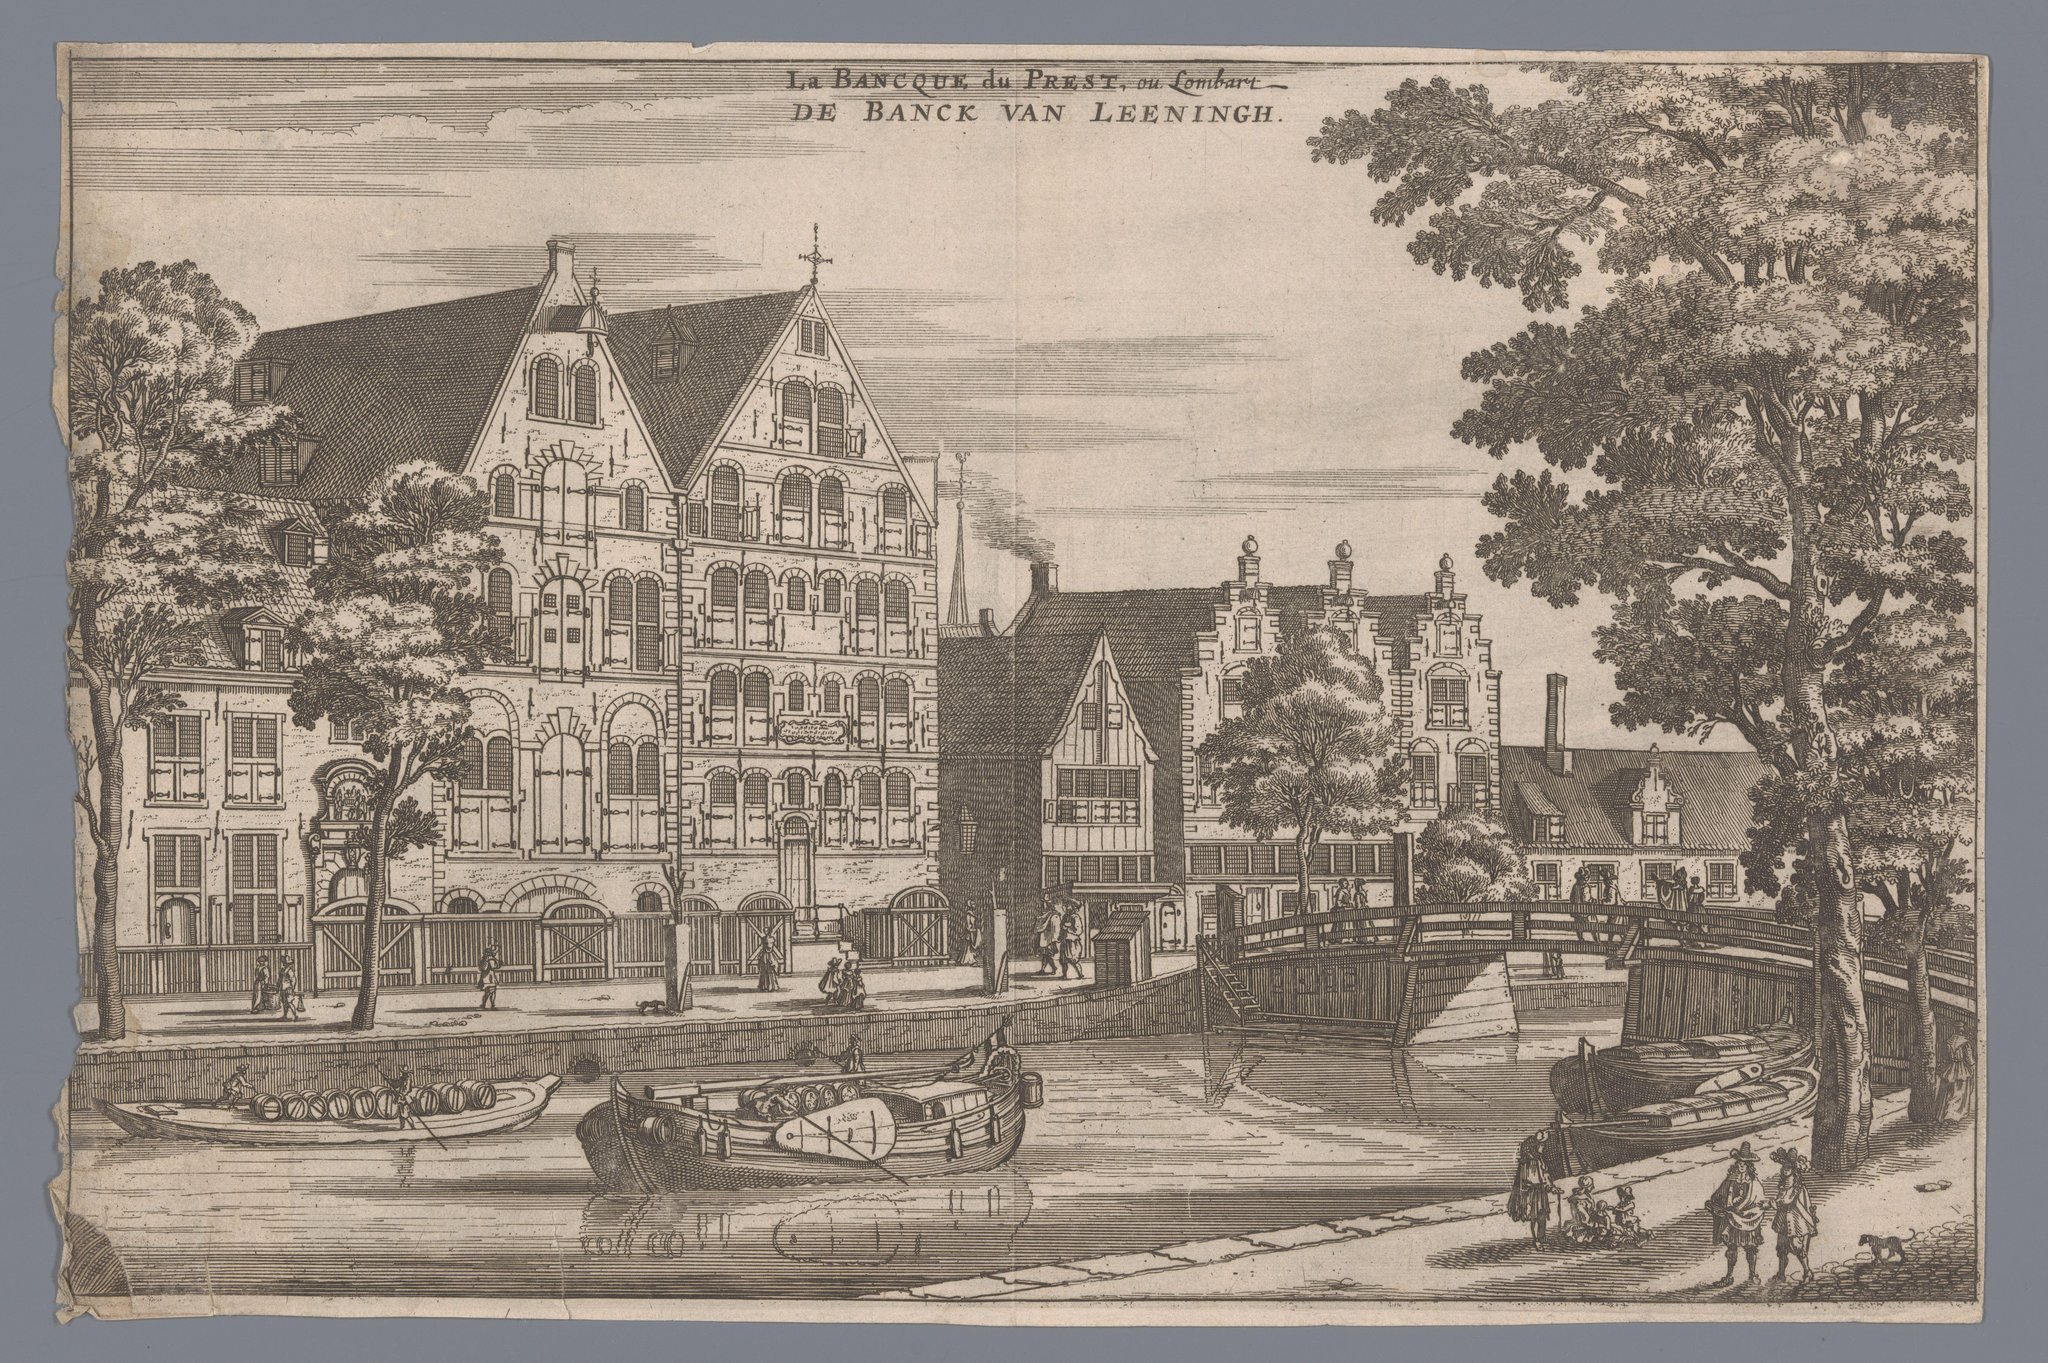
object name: print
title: La Bancque du Prest, ou Lombart / De Banck van Leeningh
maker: jacob van meurs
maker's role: draughtsman, print maker, publisher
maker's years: 1619-1680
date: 1663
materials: paper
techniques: etching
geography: amsterdam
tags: pawnbroker, lombard, bank, street (+ city(-scape) with figures, staffage)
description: Prent verschenen in: Dapper, Olfert. Historische beschryving der stadt Amsterdam: waer in de voornaemste geschiedenissen (na een kort verhael van gansch Hollant en d'omleggende dorpen (…). Amsterdam: Jacob van Meurs, 1663.